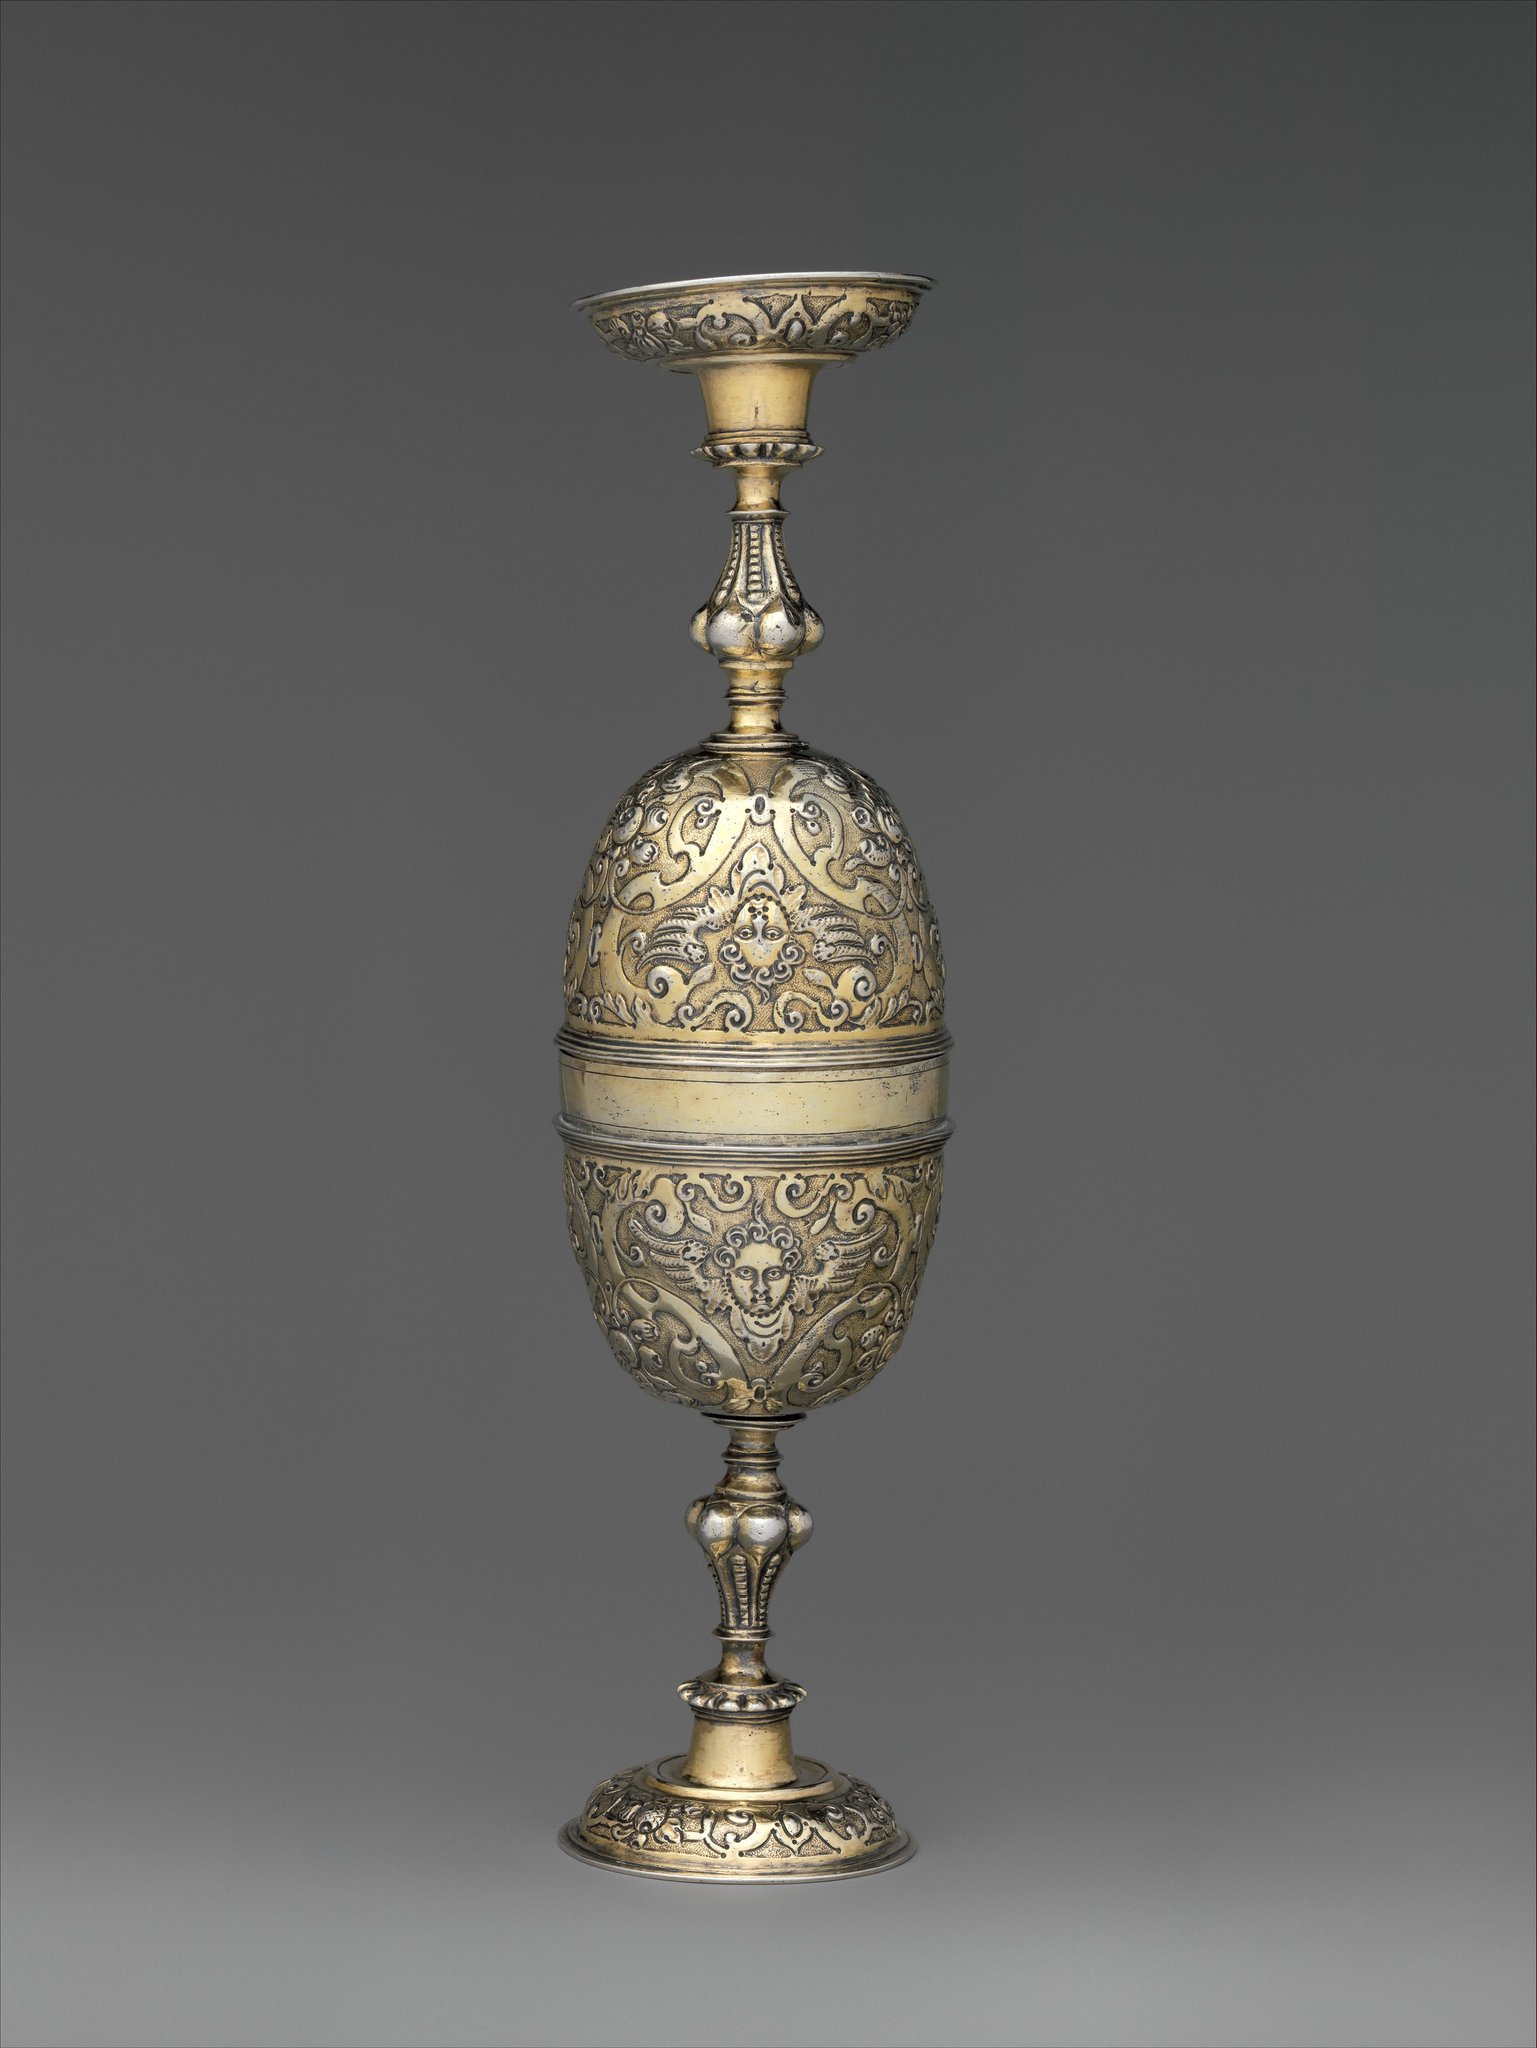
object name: double cup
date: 1600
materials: gilt silver